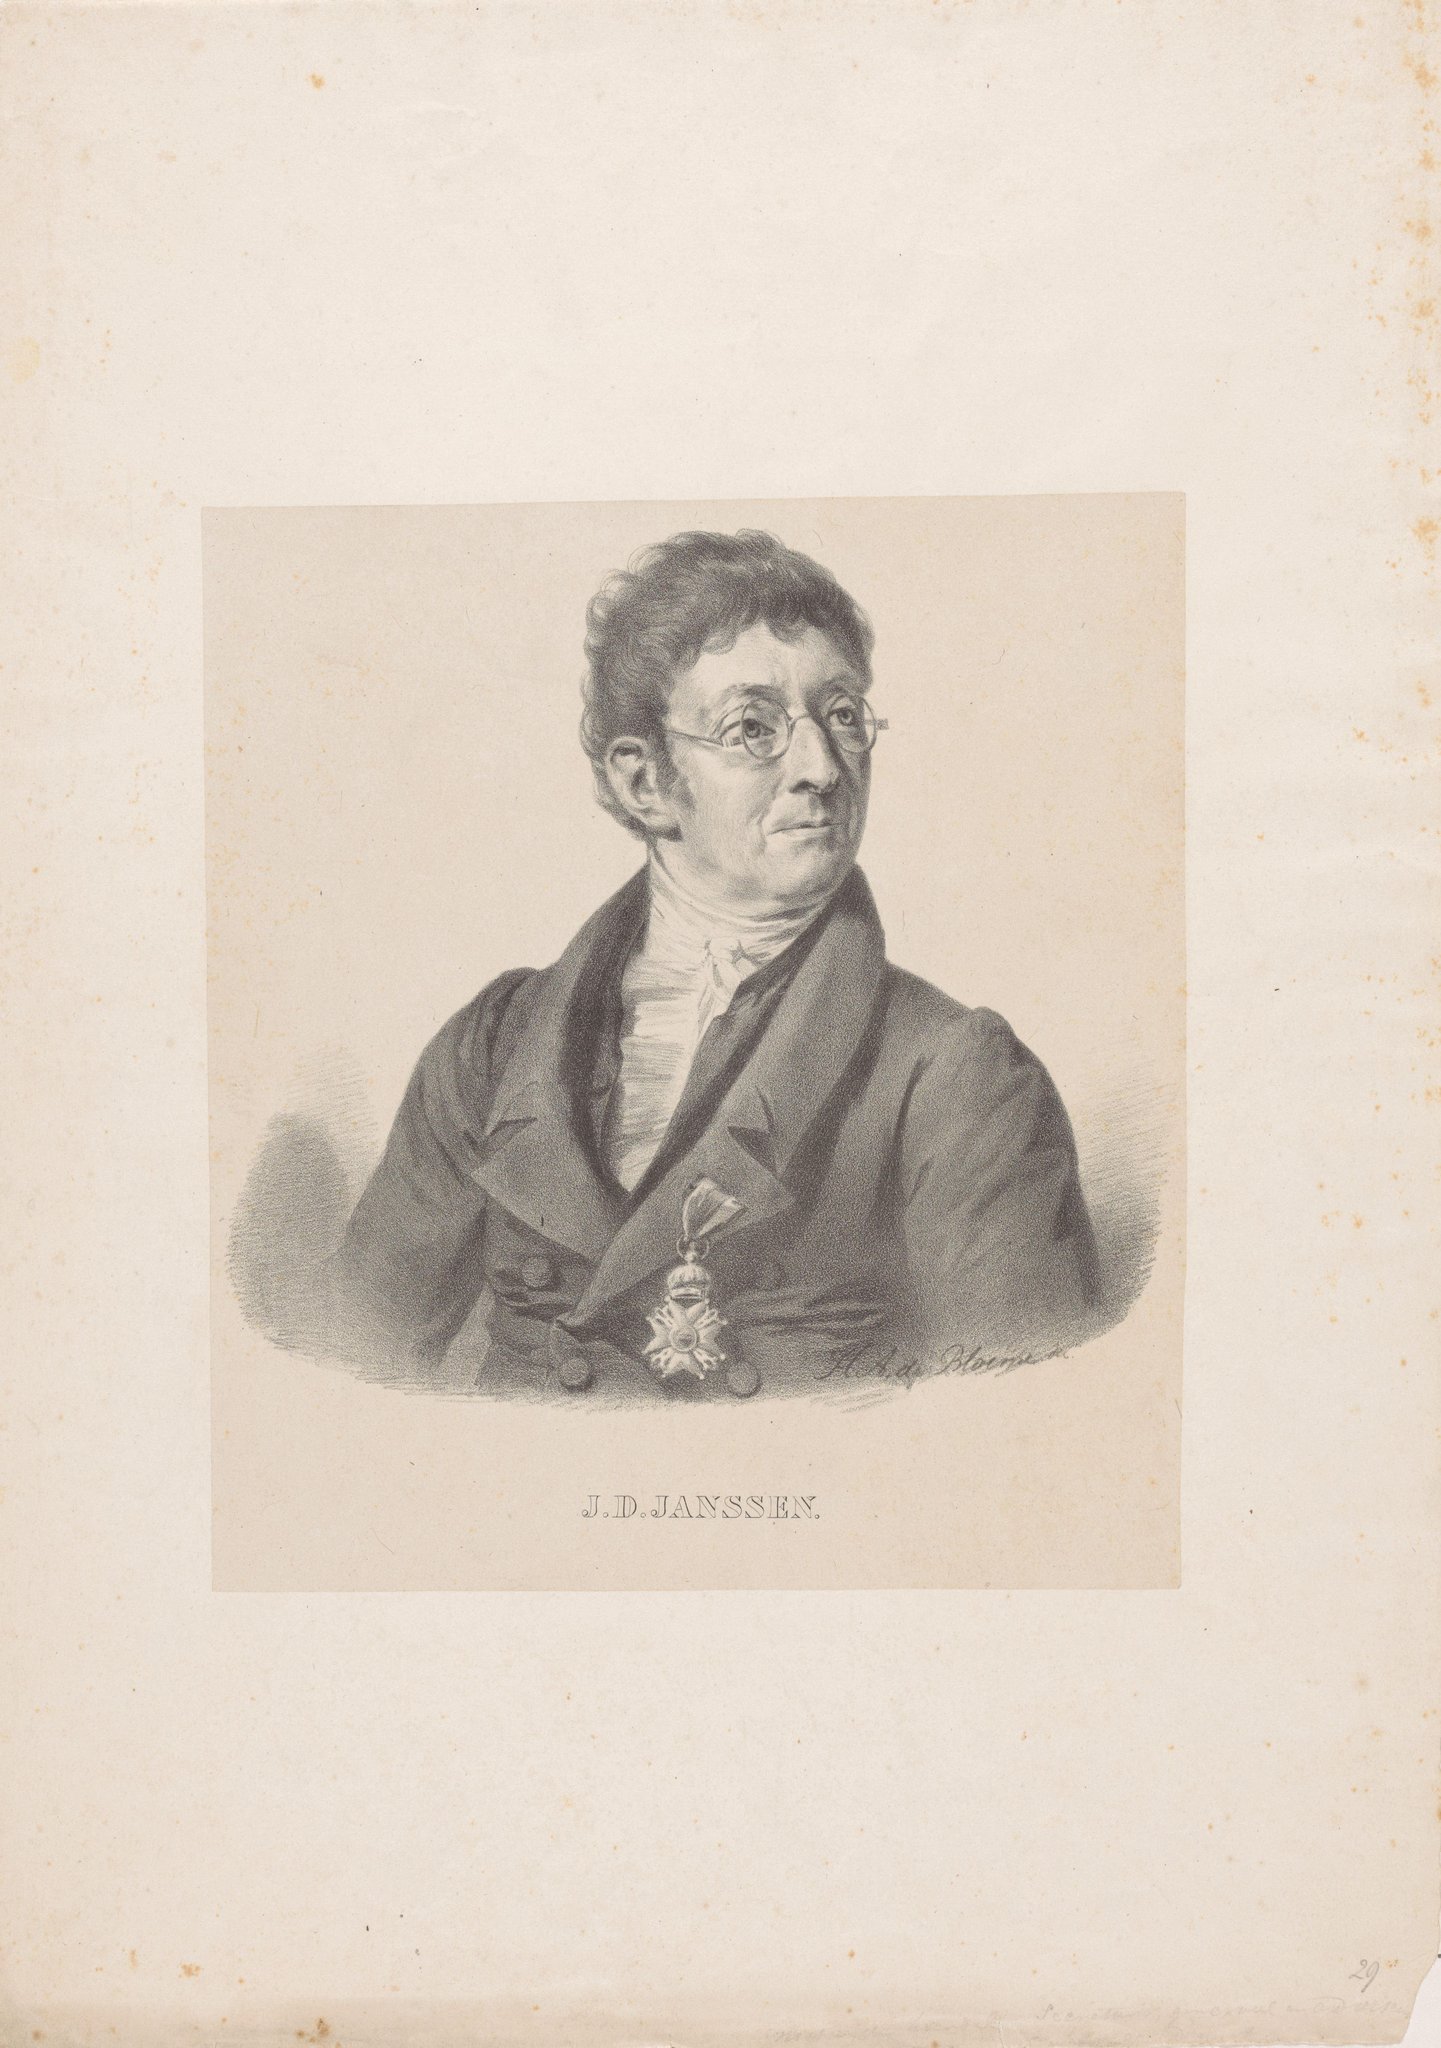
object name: print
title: Portret van Jacobus Didericus Janssen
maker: herman antonie de bloeme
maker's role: painter, print maker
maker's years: 1802-1867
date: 1812-1867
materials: paper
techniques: lithograph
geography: the hague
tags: the hague, official, eyeglasses, spectacles, knighthood order, historical persons (+ (full) bust portrait)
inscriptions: inscription:, collector's mark: Lugt 2228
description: De geportretteerde kijkt naar rechts en draagt een ridderorde op de revers van zijn jas. Onder het portret zijn naam.